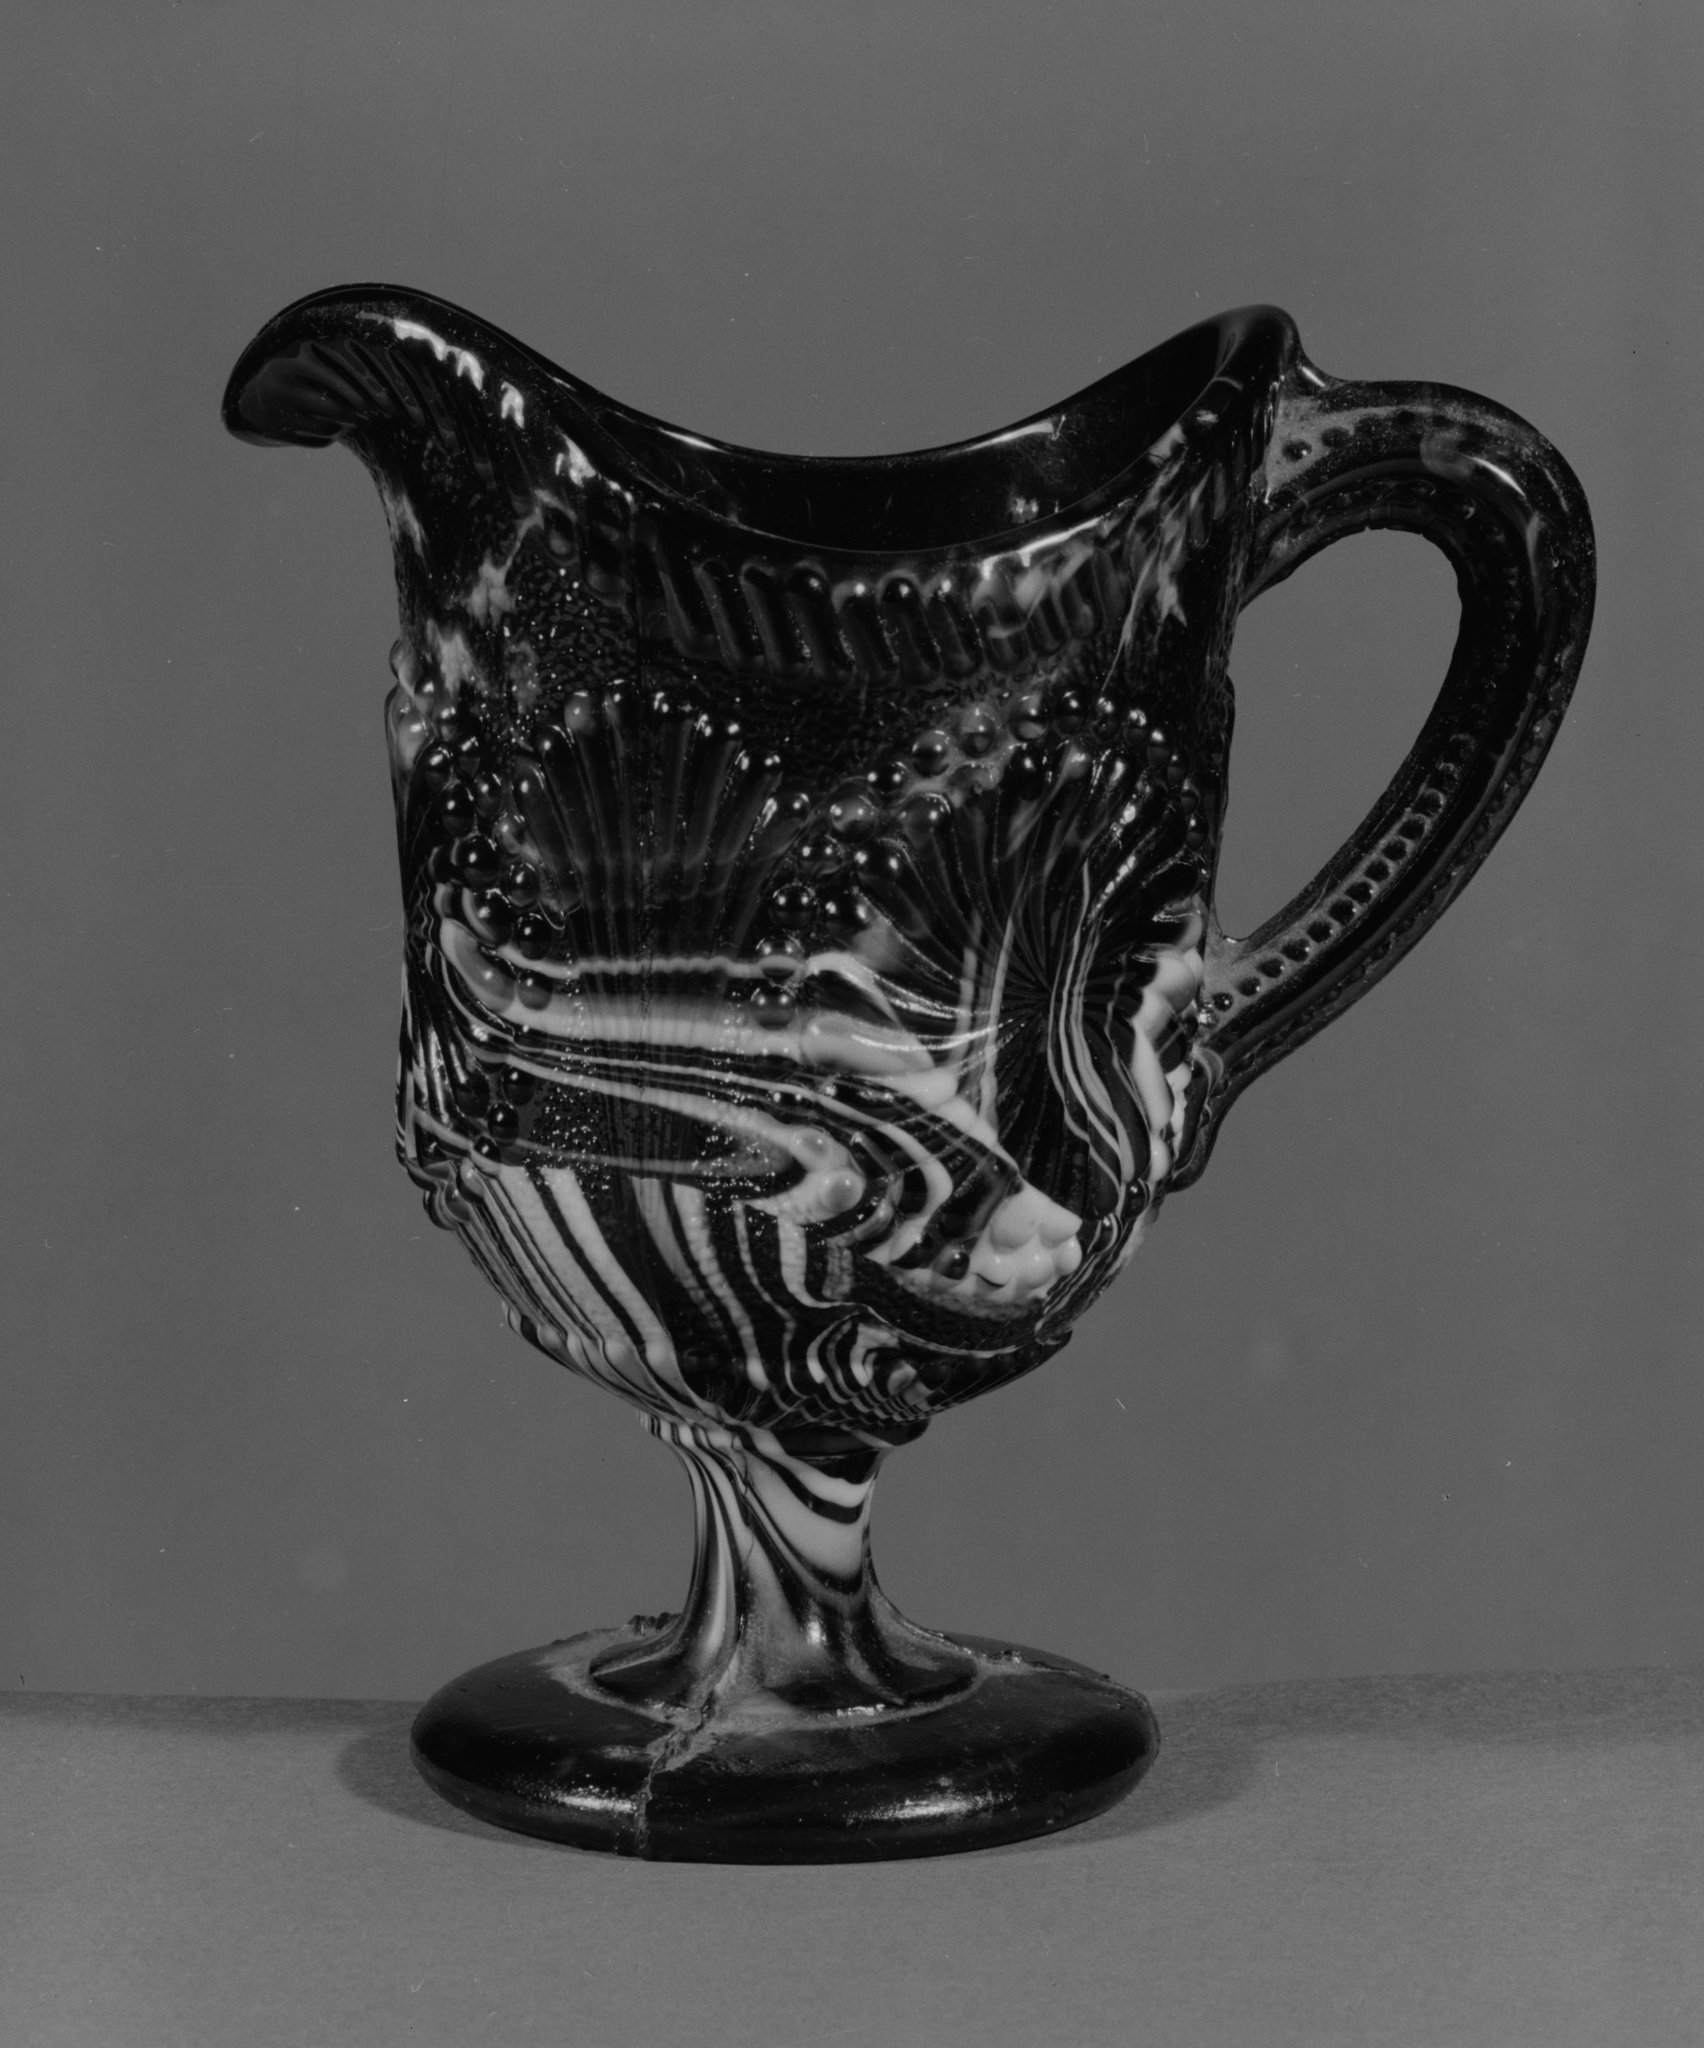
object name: cream pot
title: Creamer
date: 1880-1890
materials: glass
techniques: pressed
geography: england